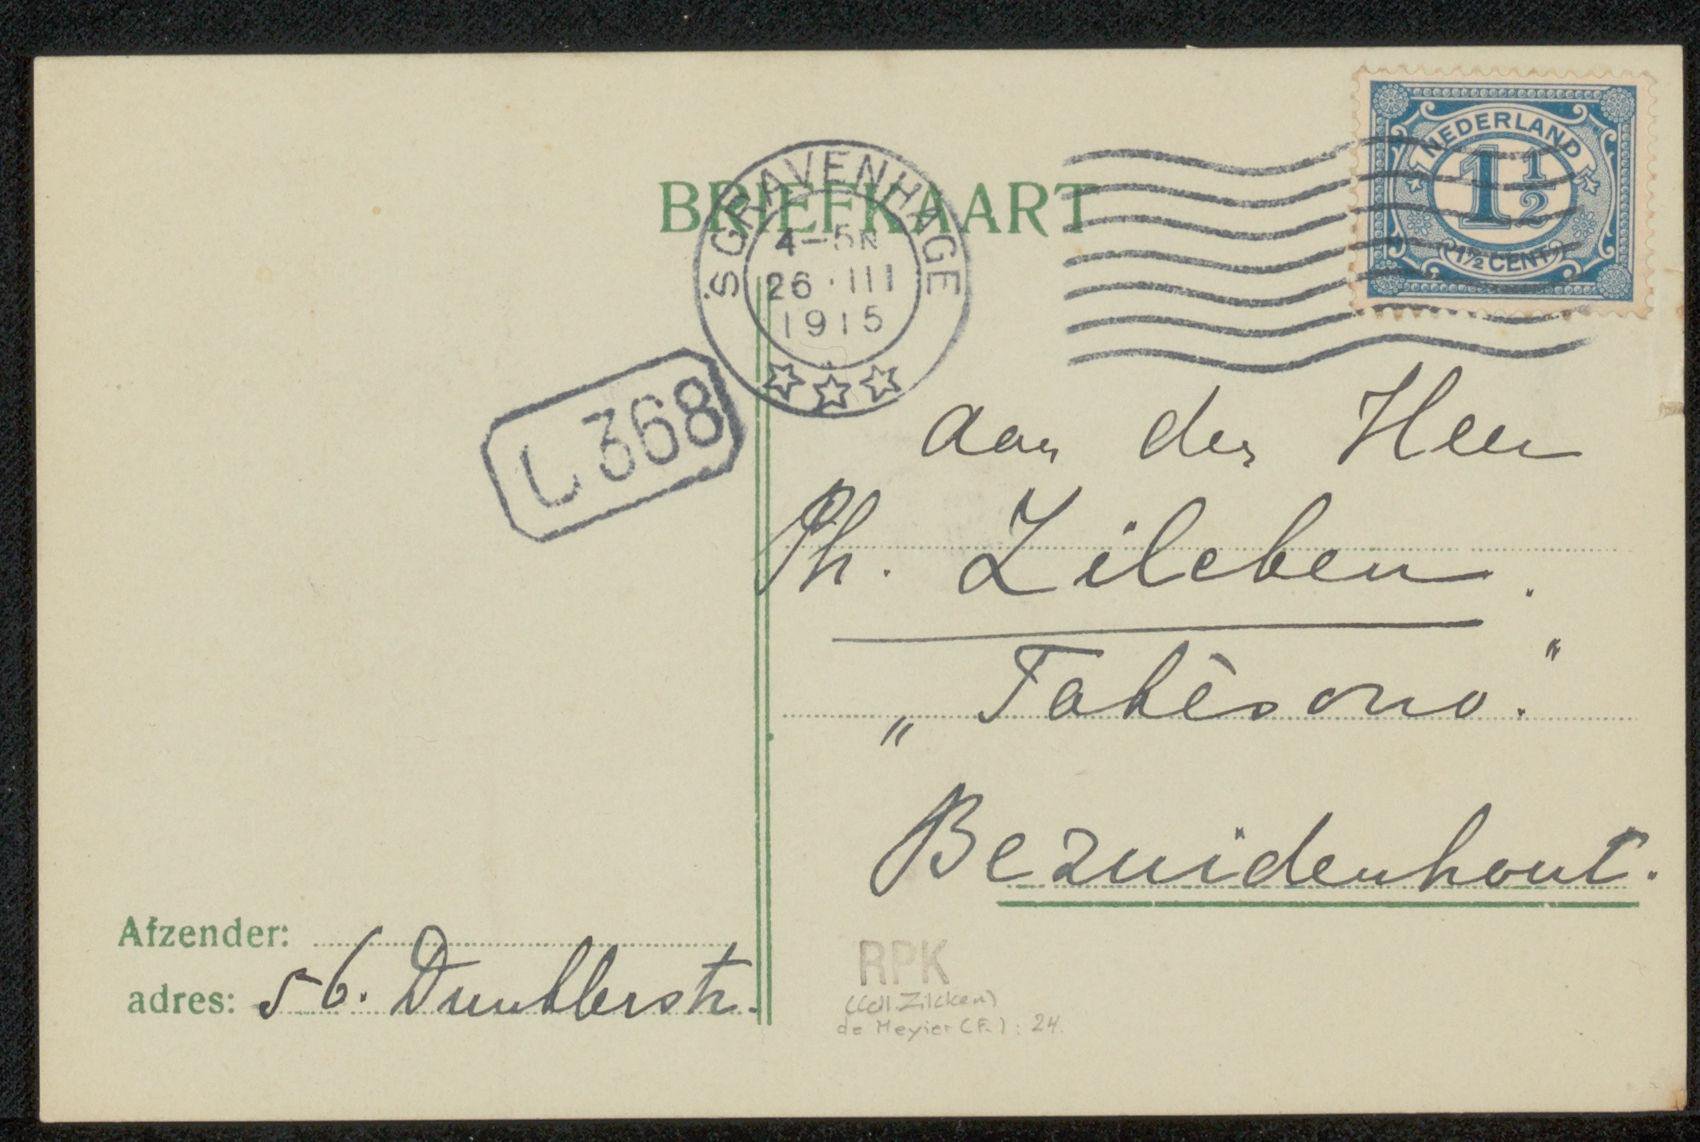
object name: postcard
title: Briefkaart aan Philip Zilcken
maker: fenna de meyier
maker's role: onderwijzer, schrijver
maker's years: 1874-1943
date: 1915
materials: cardboard, ink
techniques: pen, writing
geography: the hague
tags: the hague, painter, philip zilcken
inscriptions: collector's mark: ‘RPK’